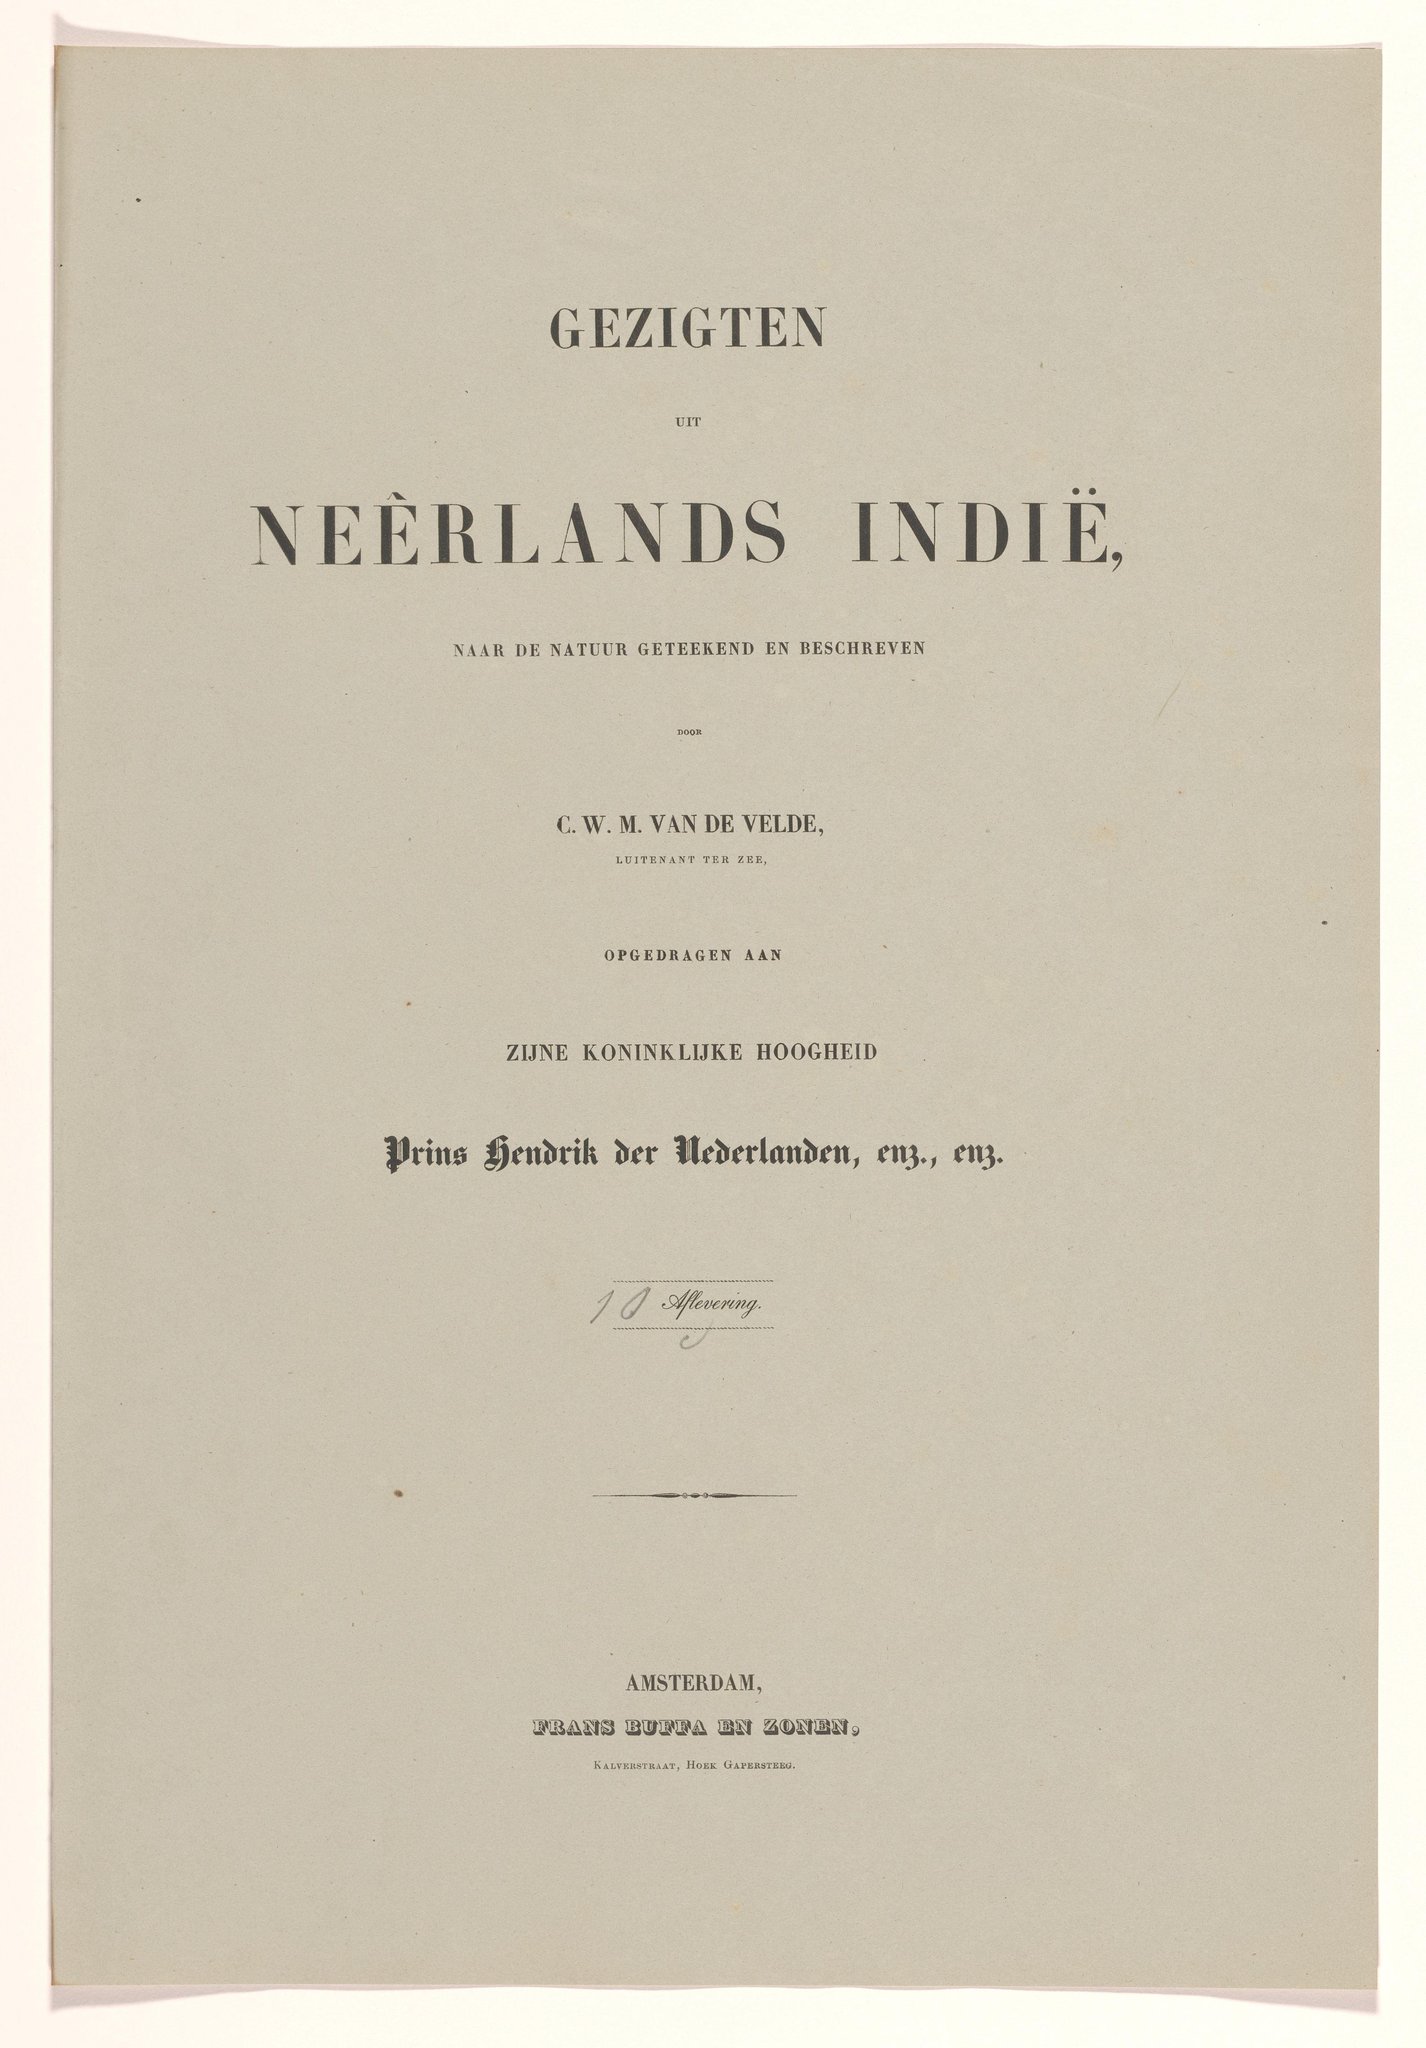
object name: wrapper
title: Omslag met tekstbladen en prenten over Nederlands Indië: tiende aflevering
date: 1843-1845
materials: paper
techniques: lithograph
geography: amsterdam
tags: landscapes in the non-temperate zone, exotic landscapes, dutch east indies, the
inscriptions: inscription: ‘10 C’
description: Omslag met zes losse bladen waaronder drie tekstbladen en drie lithografieën. De omslag maakt deel uit van een map met twaalf omslagen.